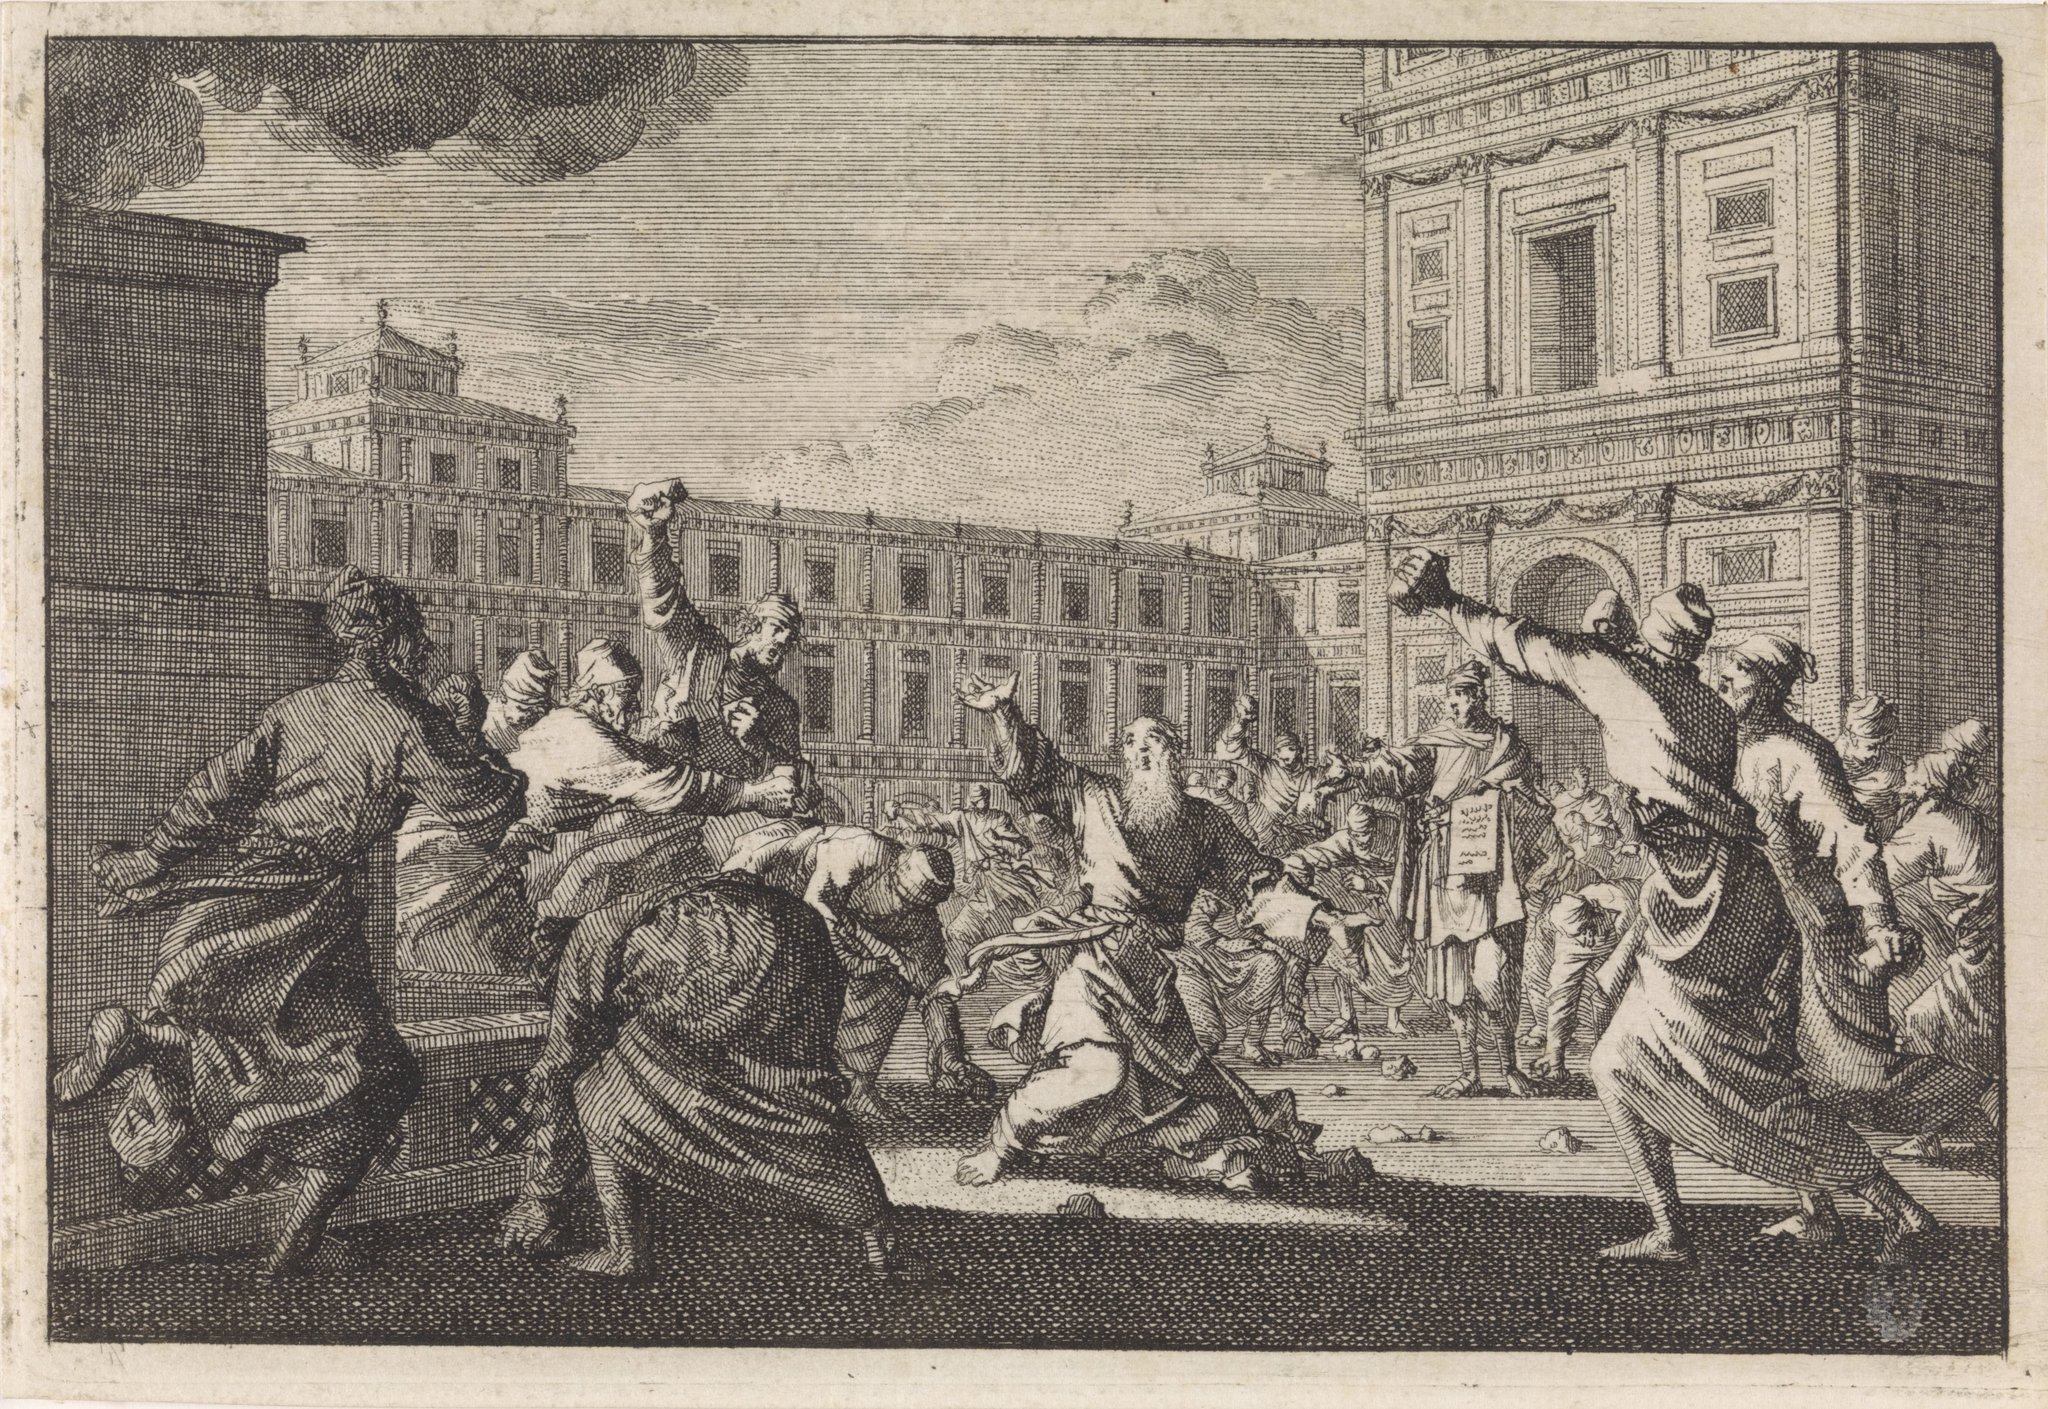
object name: print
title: Steniging van Zacharias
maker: jan luyken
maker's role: draughtsman, print maker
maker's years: 1649-1712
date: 1704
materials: paper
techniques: etching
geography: amsterdam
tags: the murder of zacharias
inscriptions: collector's mark: Lugt 2228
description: Prent ook gebruikt als boekillustratie in: Josephus, Flavius. Alle de Werken, 2 delen. Amsterdam: Pieter Mortier, 1704, dl. 1, p. 225.